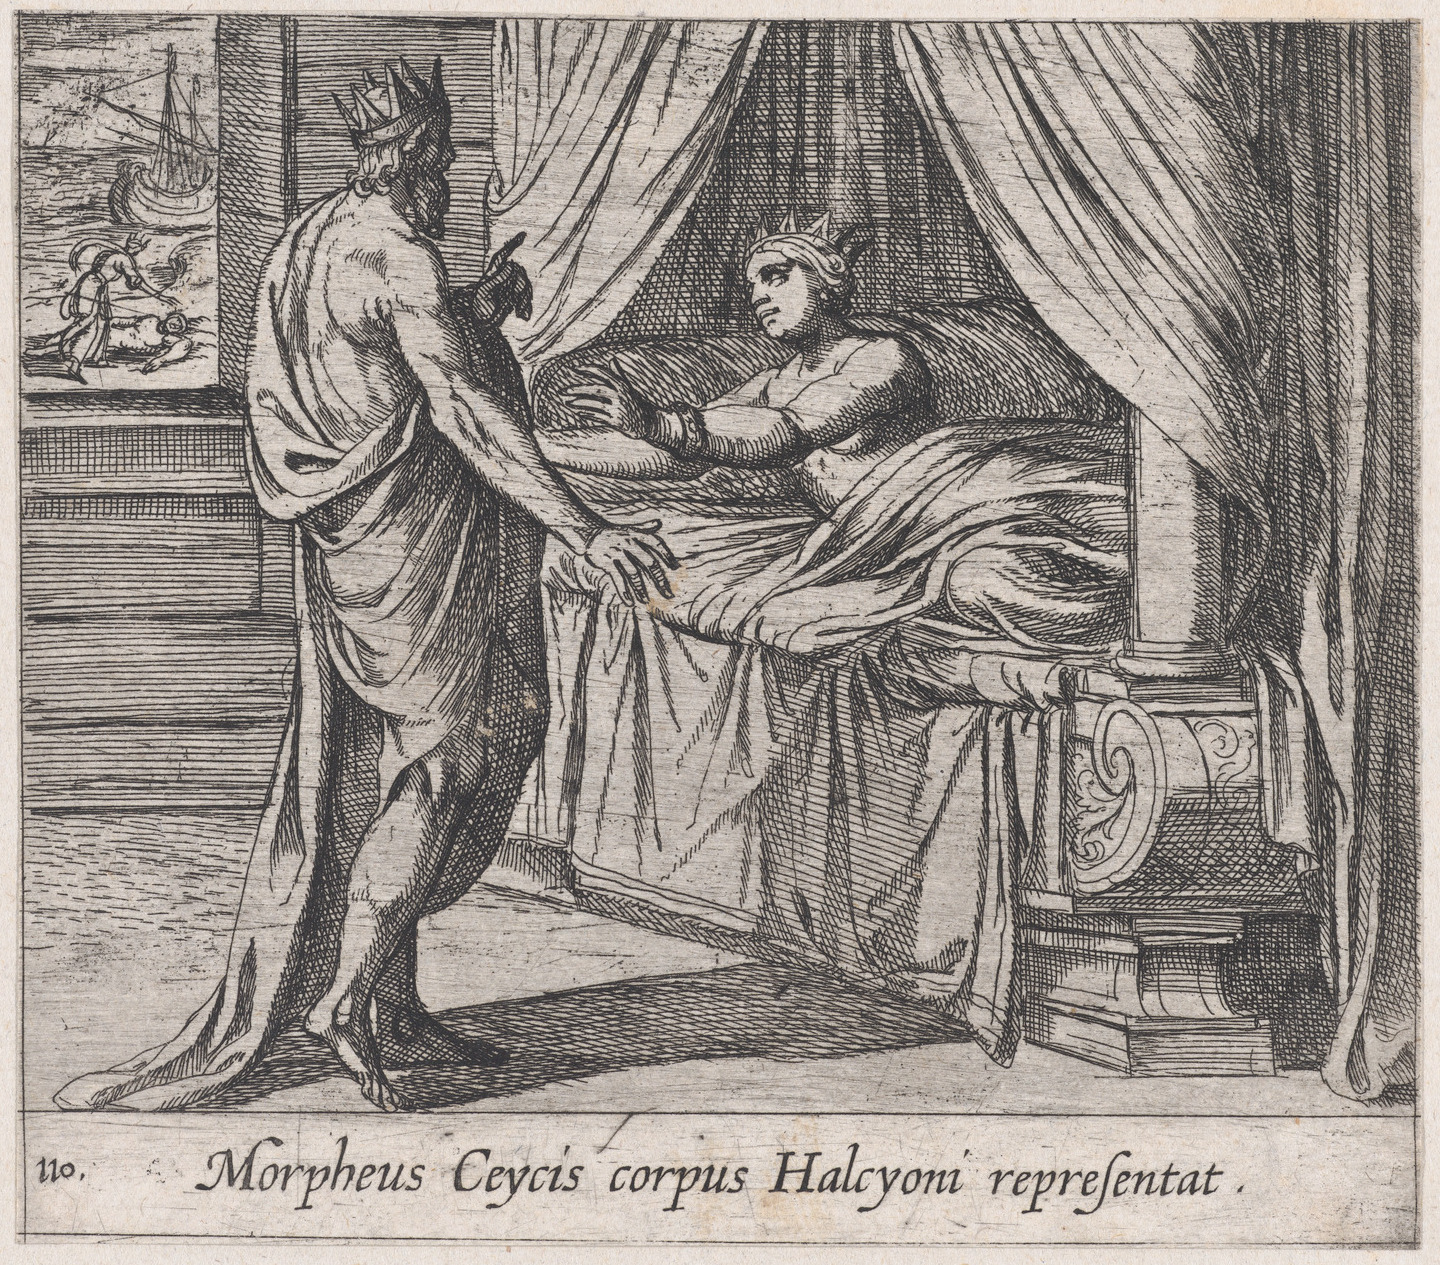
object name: print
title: Plate 110: Morpheus, as Ceyx, Appearing to Alcyone (Morpheus Ceycis corpus Halcyoni representat), from Ovid's 'Metamorphoses'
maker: antonio tempesta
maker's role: artist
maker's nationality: italian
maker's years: 1555-1630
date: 1606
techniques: etching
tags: men,women,beds